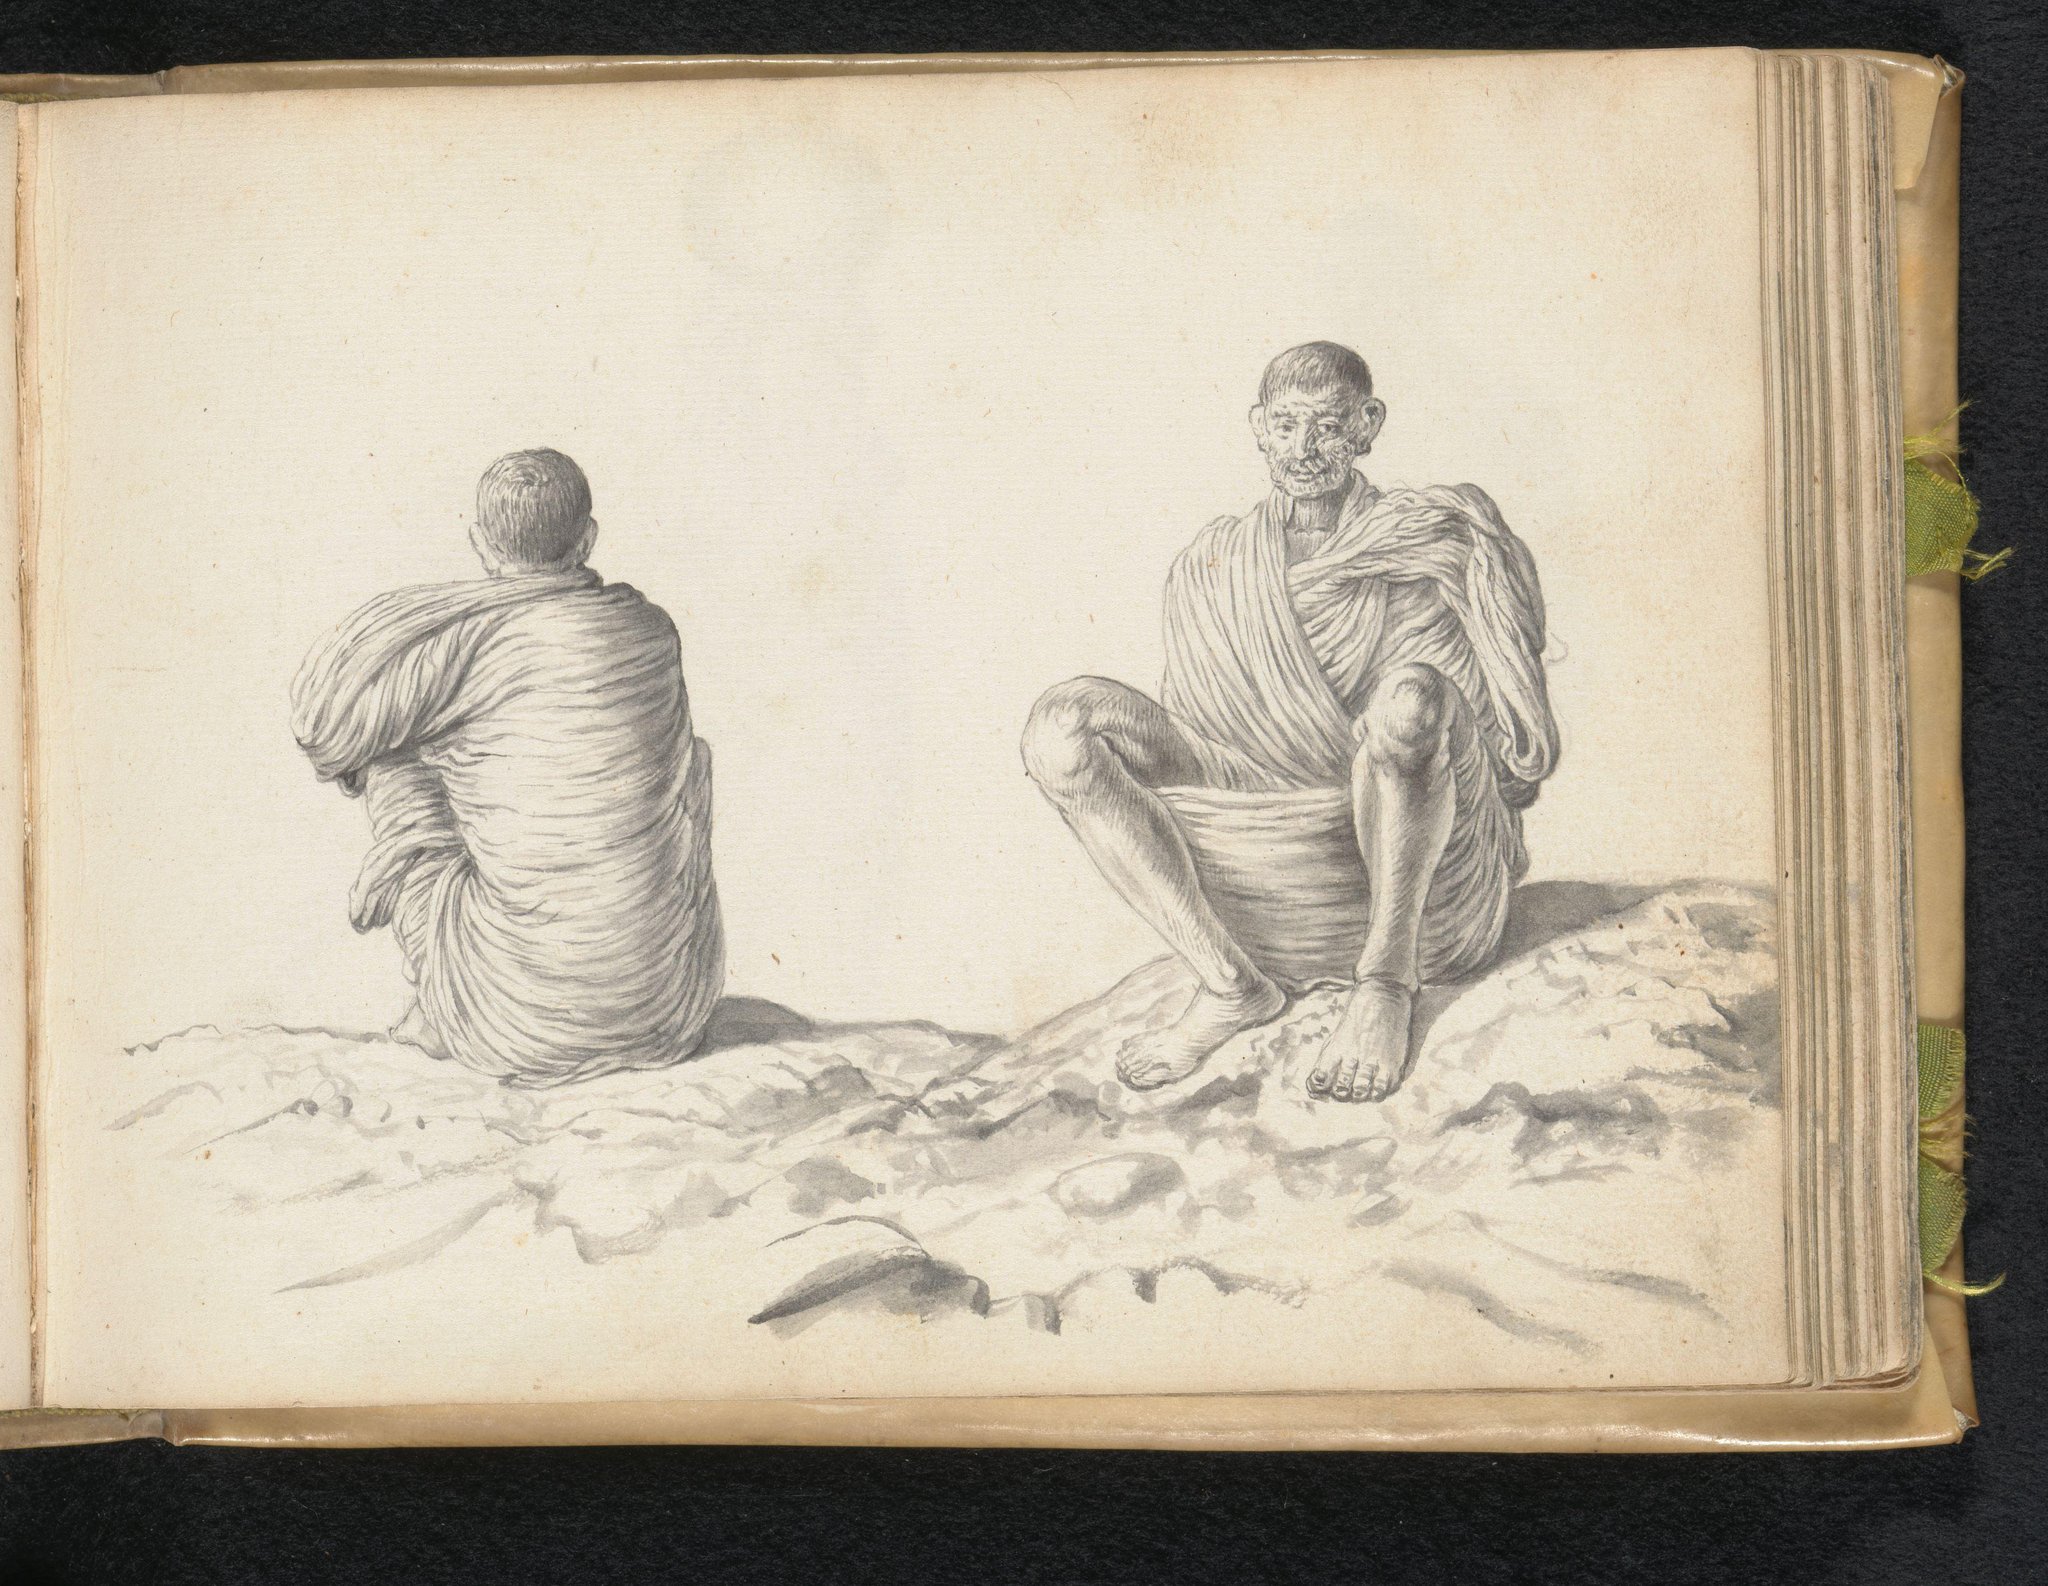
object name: sketchbook leaf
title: Two labourers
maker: esaias boursse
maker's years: 1631-1672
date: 1662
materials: ink, paper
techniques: brush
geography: sri lanka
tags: 41d232(...) skirt (lungi), head-gear (with name), asiatic races and peoples: indians, sri lanka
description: Buiten op een oneffen terrein zitten twee mannen op de grond met opgetrokken knieën. Beide mannen dragen een heupkleed (veshti, lungi) opgeschort tot boven de knieën; om bovenlijf en armen hebben ze een grote omslagdoek (chadar) gewikkeld. De links zittende man steunt zijn bedekte linkerelleboog op de linkerknie. De man rechts lijkt zijn armen onder de schouderdoek voor zijn borst gevouwen te houden. Zijn voeten staan stevig voor hem op de hellende grond. Van beide mannen is het haar kort geknipt of geschoren. De mannen zijn waarschijnlijk afkomstig van Zuid-India en in Colombo te werk gesteld in de wederopbouw. Mogelijk is het dezelfde man, twee keer getekend. Blad 45 uit een schetsboek met 117 bladen.